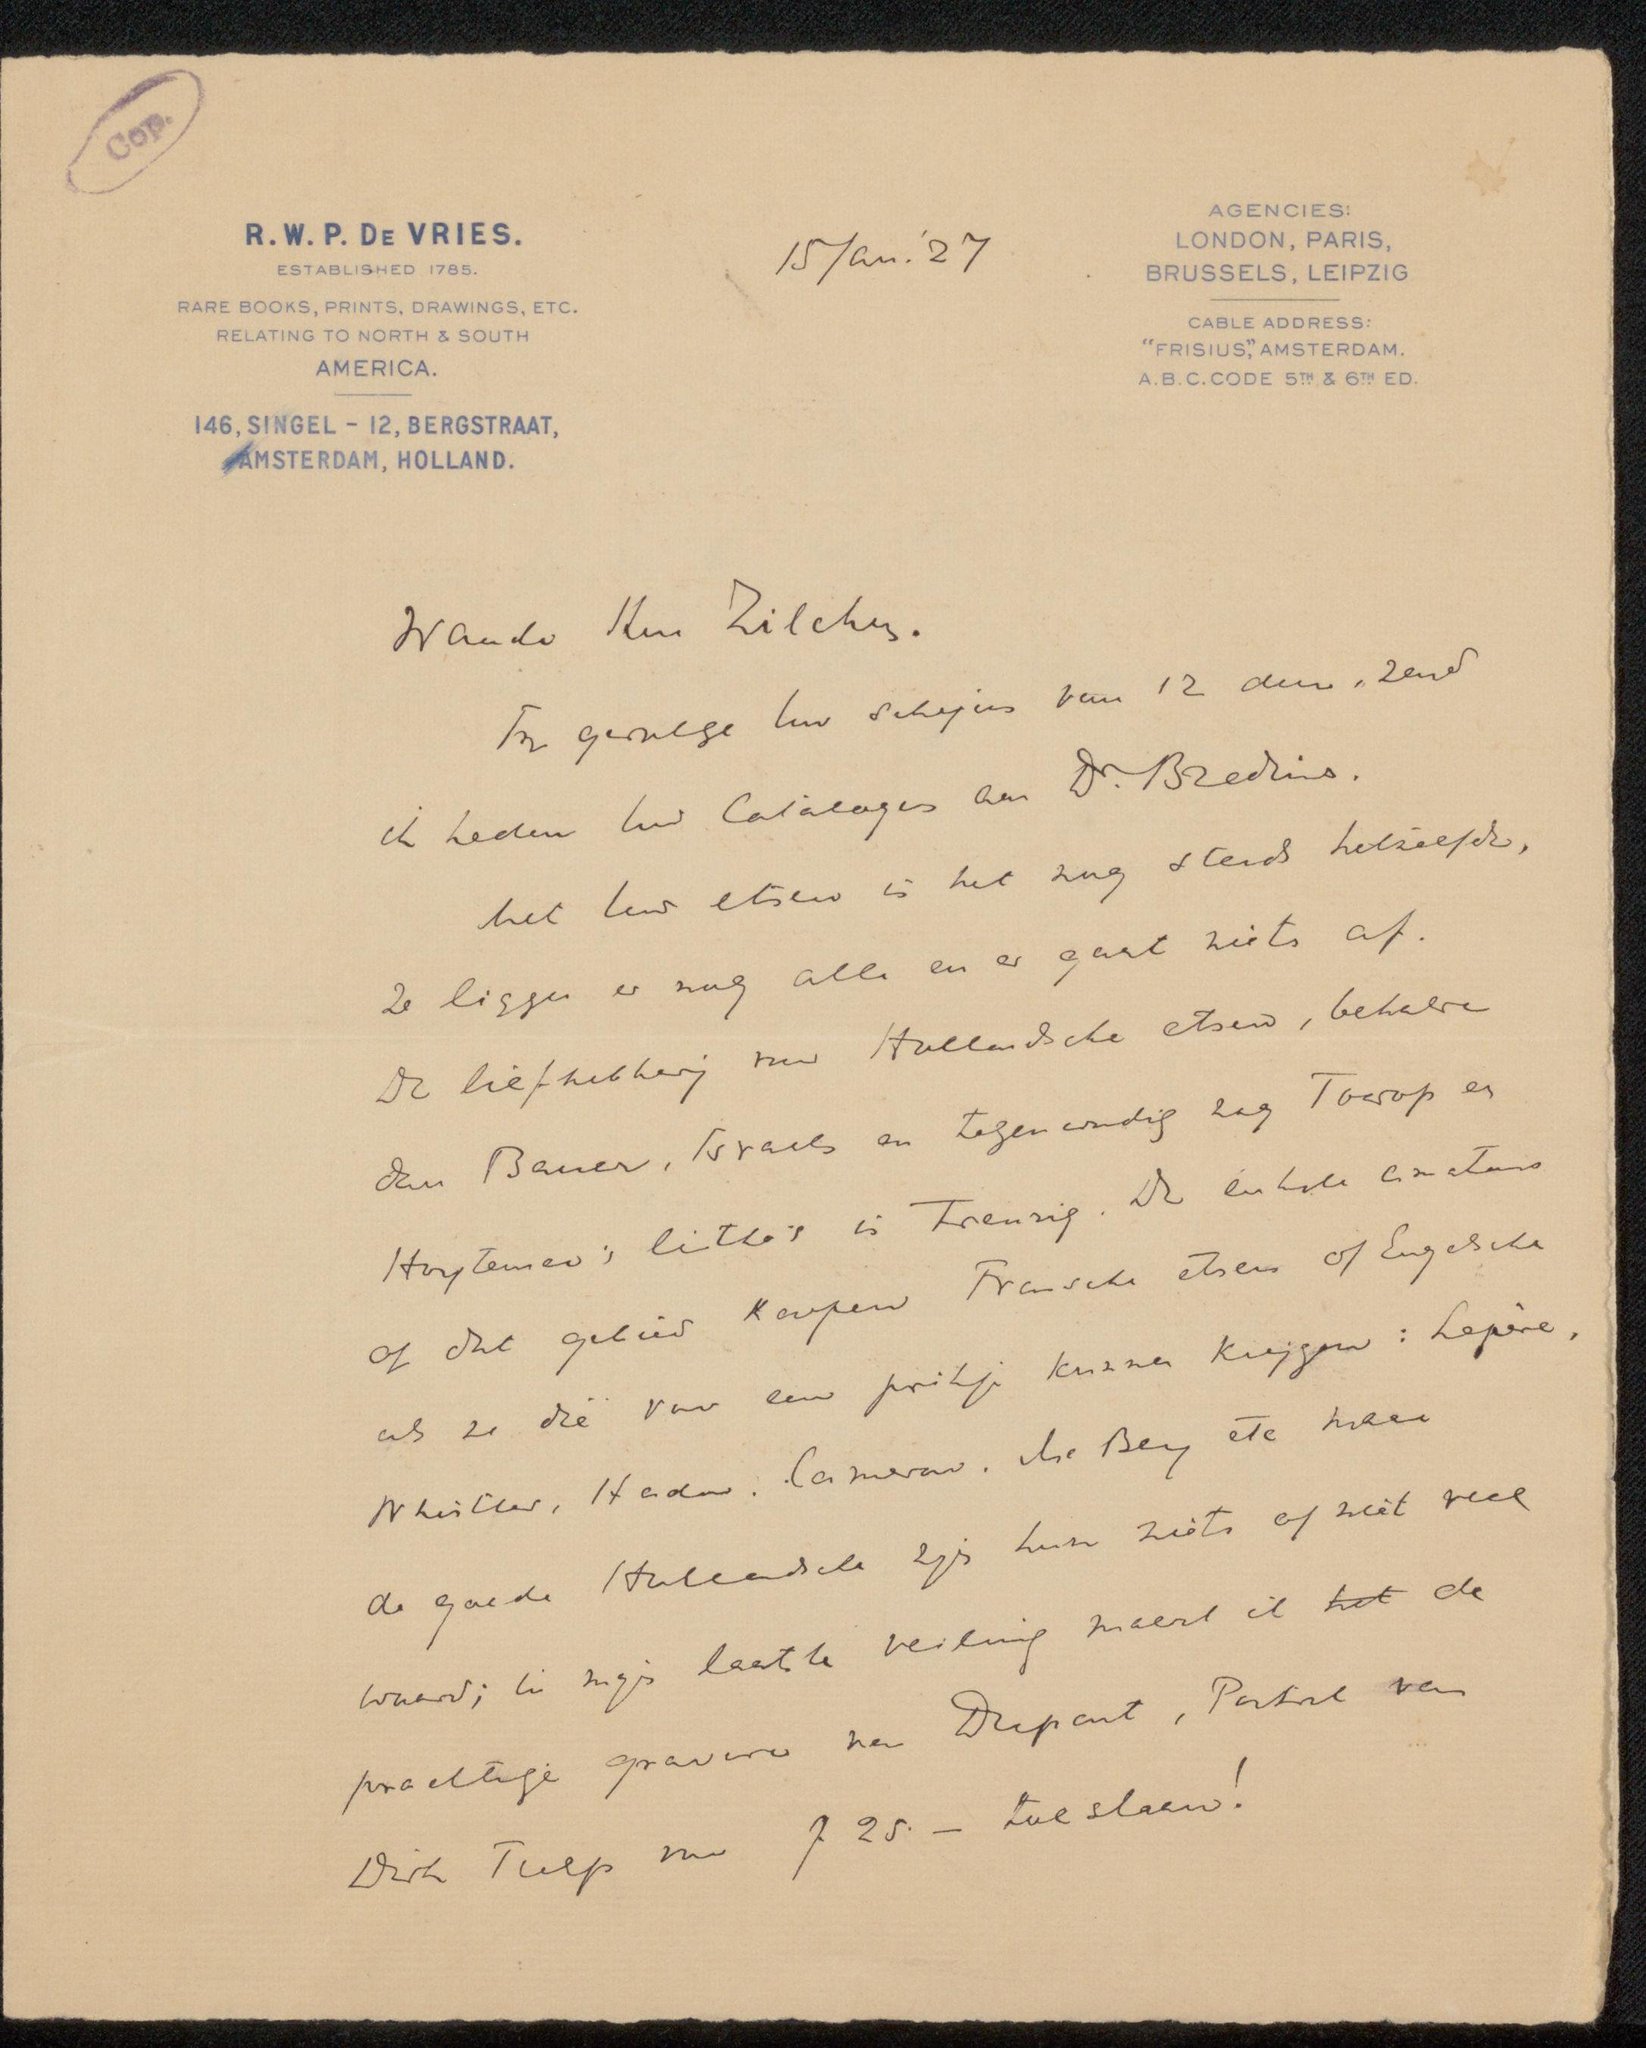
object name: letter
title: Brief aan Philip Zilcken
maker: Anonymous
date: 1927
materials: ink, paper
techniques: pen, printing, writing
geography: amsterdam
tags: the hague, painter, print maker, draughtsman, jozef israëls, auguste lepère, glasgow, david young cameron, theo van hoytema, marius bauer, jan toorop, pieter dupont, james abbott mcneill whistler, abraham bredius, philip zilcken, art trade, art shop, drawing, the graphic arts, art collecting, money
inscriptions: stamp: ‘Cop.’, collector's mark: ‘RPK’